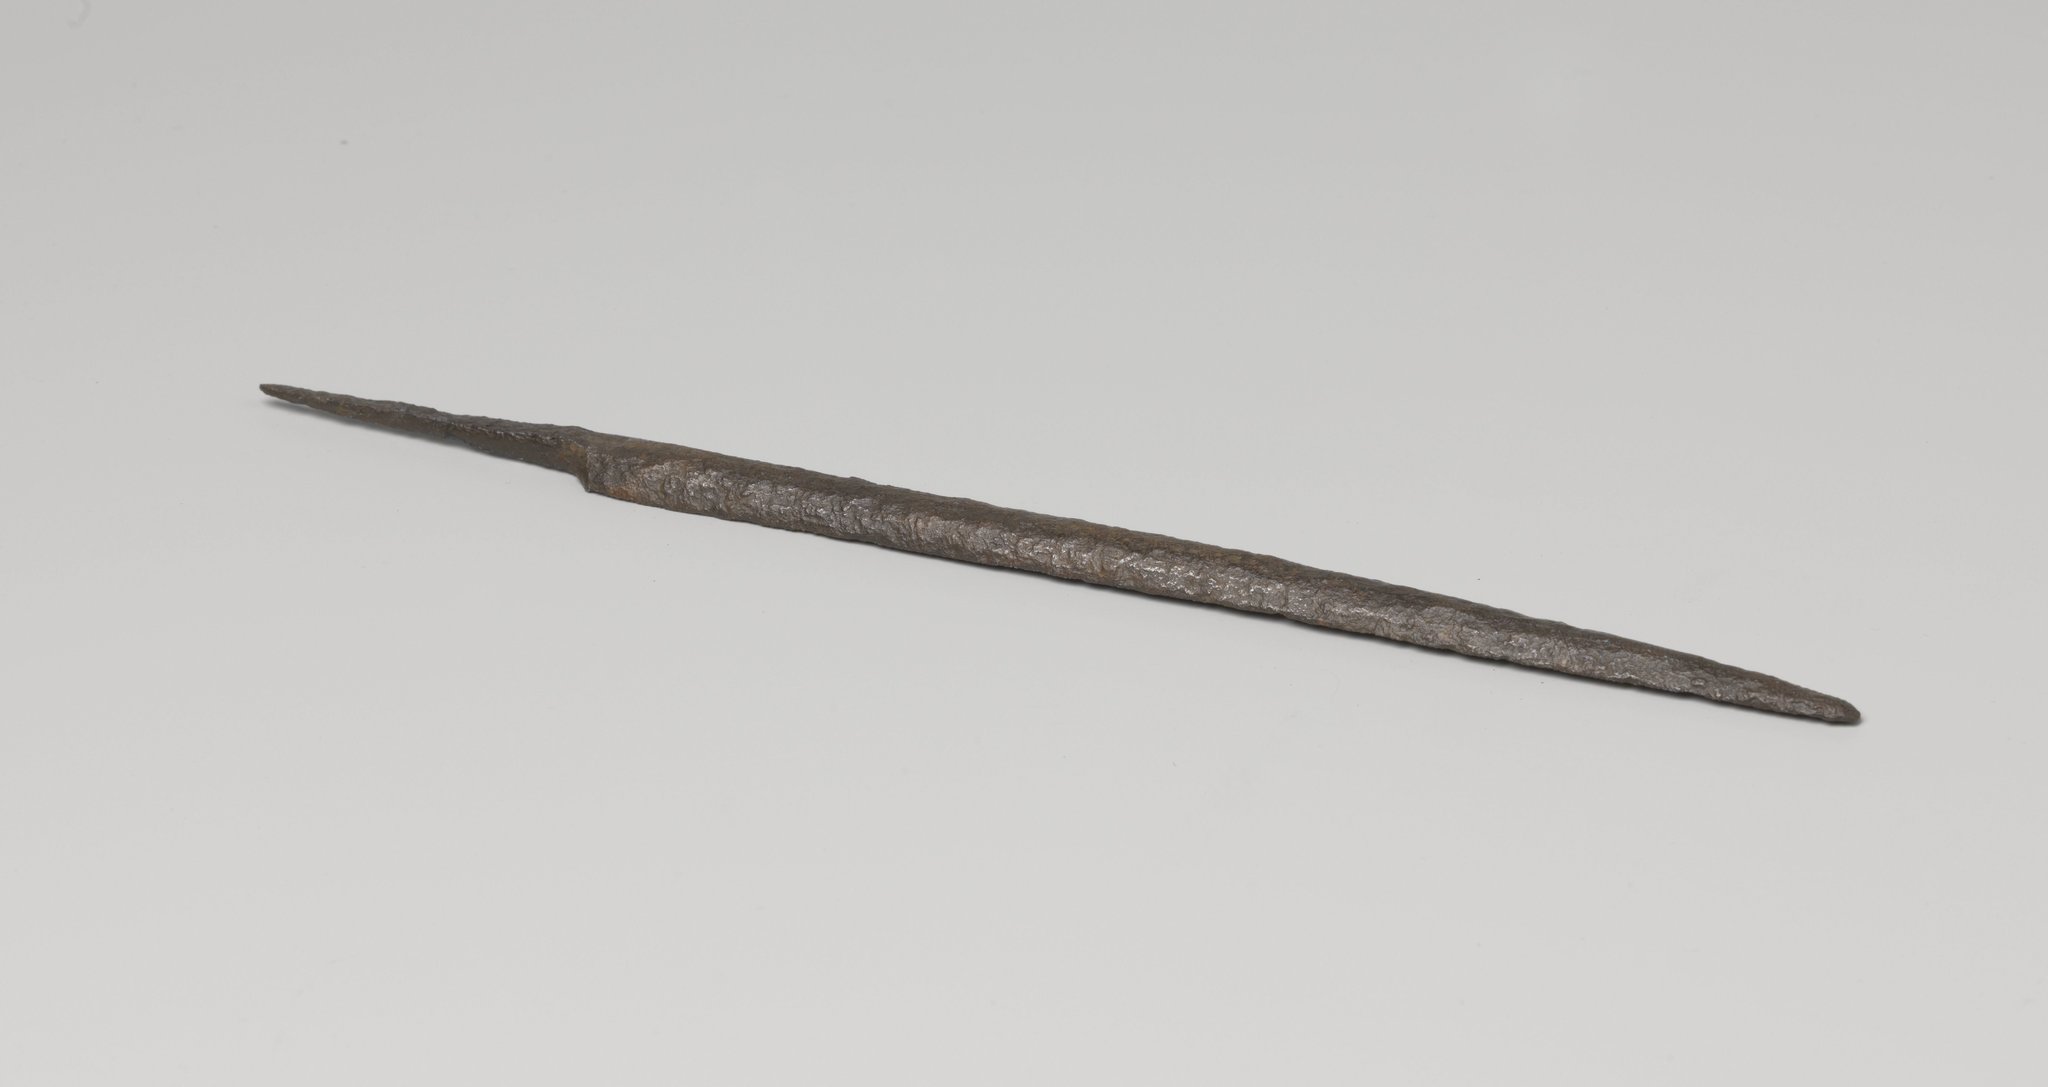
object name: file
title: Halfronde dubbelzijdige vijl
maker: Anonymous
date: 1590-1596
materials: iron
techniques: forging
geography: netherlands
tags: willem barendsz., amsterdam, jacob van heemskerck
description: Semicircular and flat files and raspers